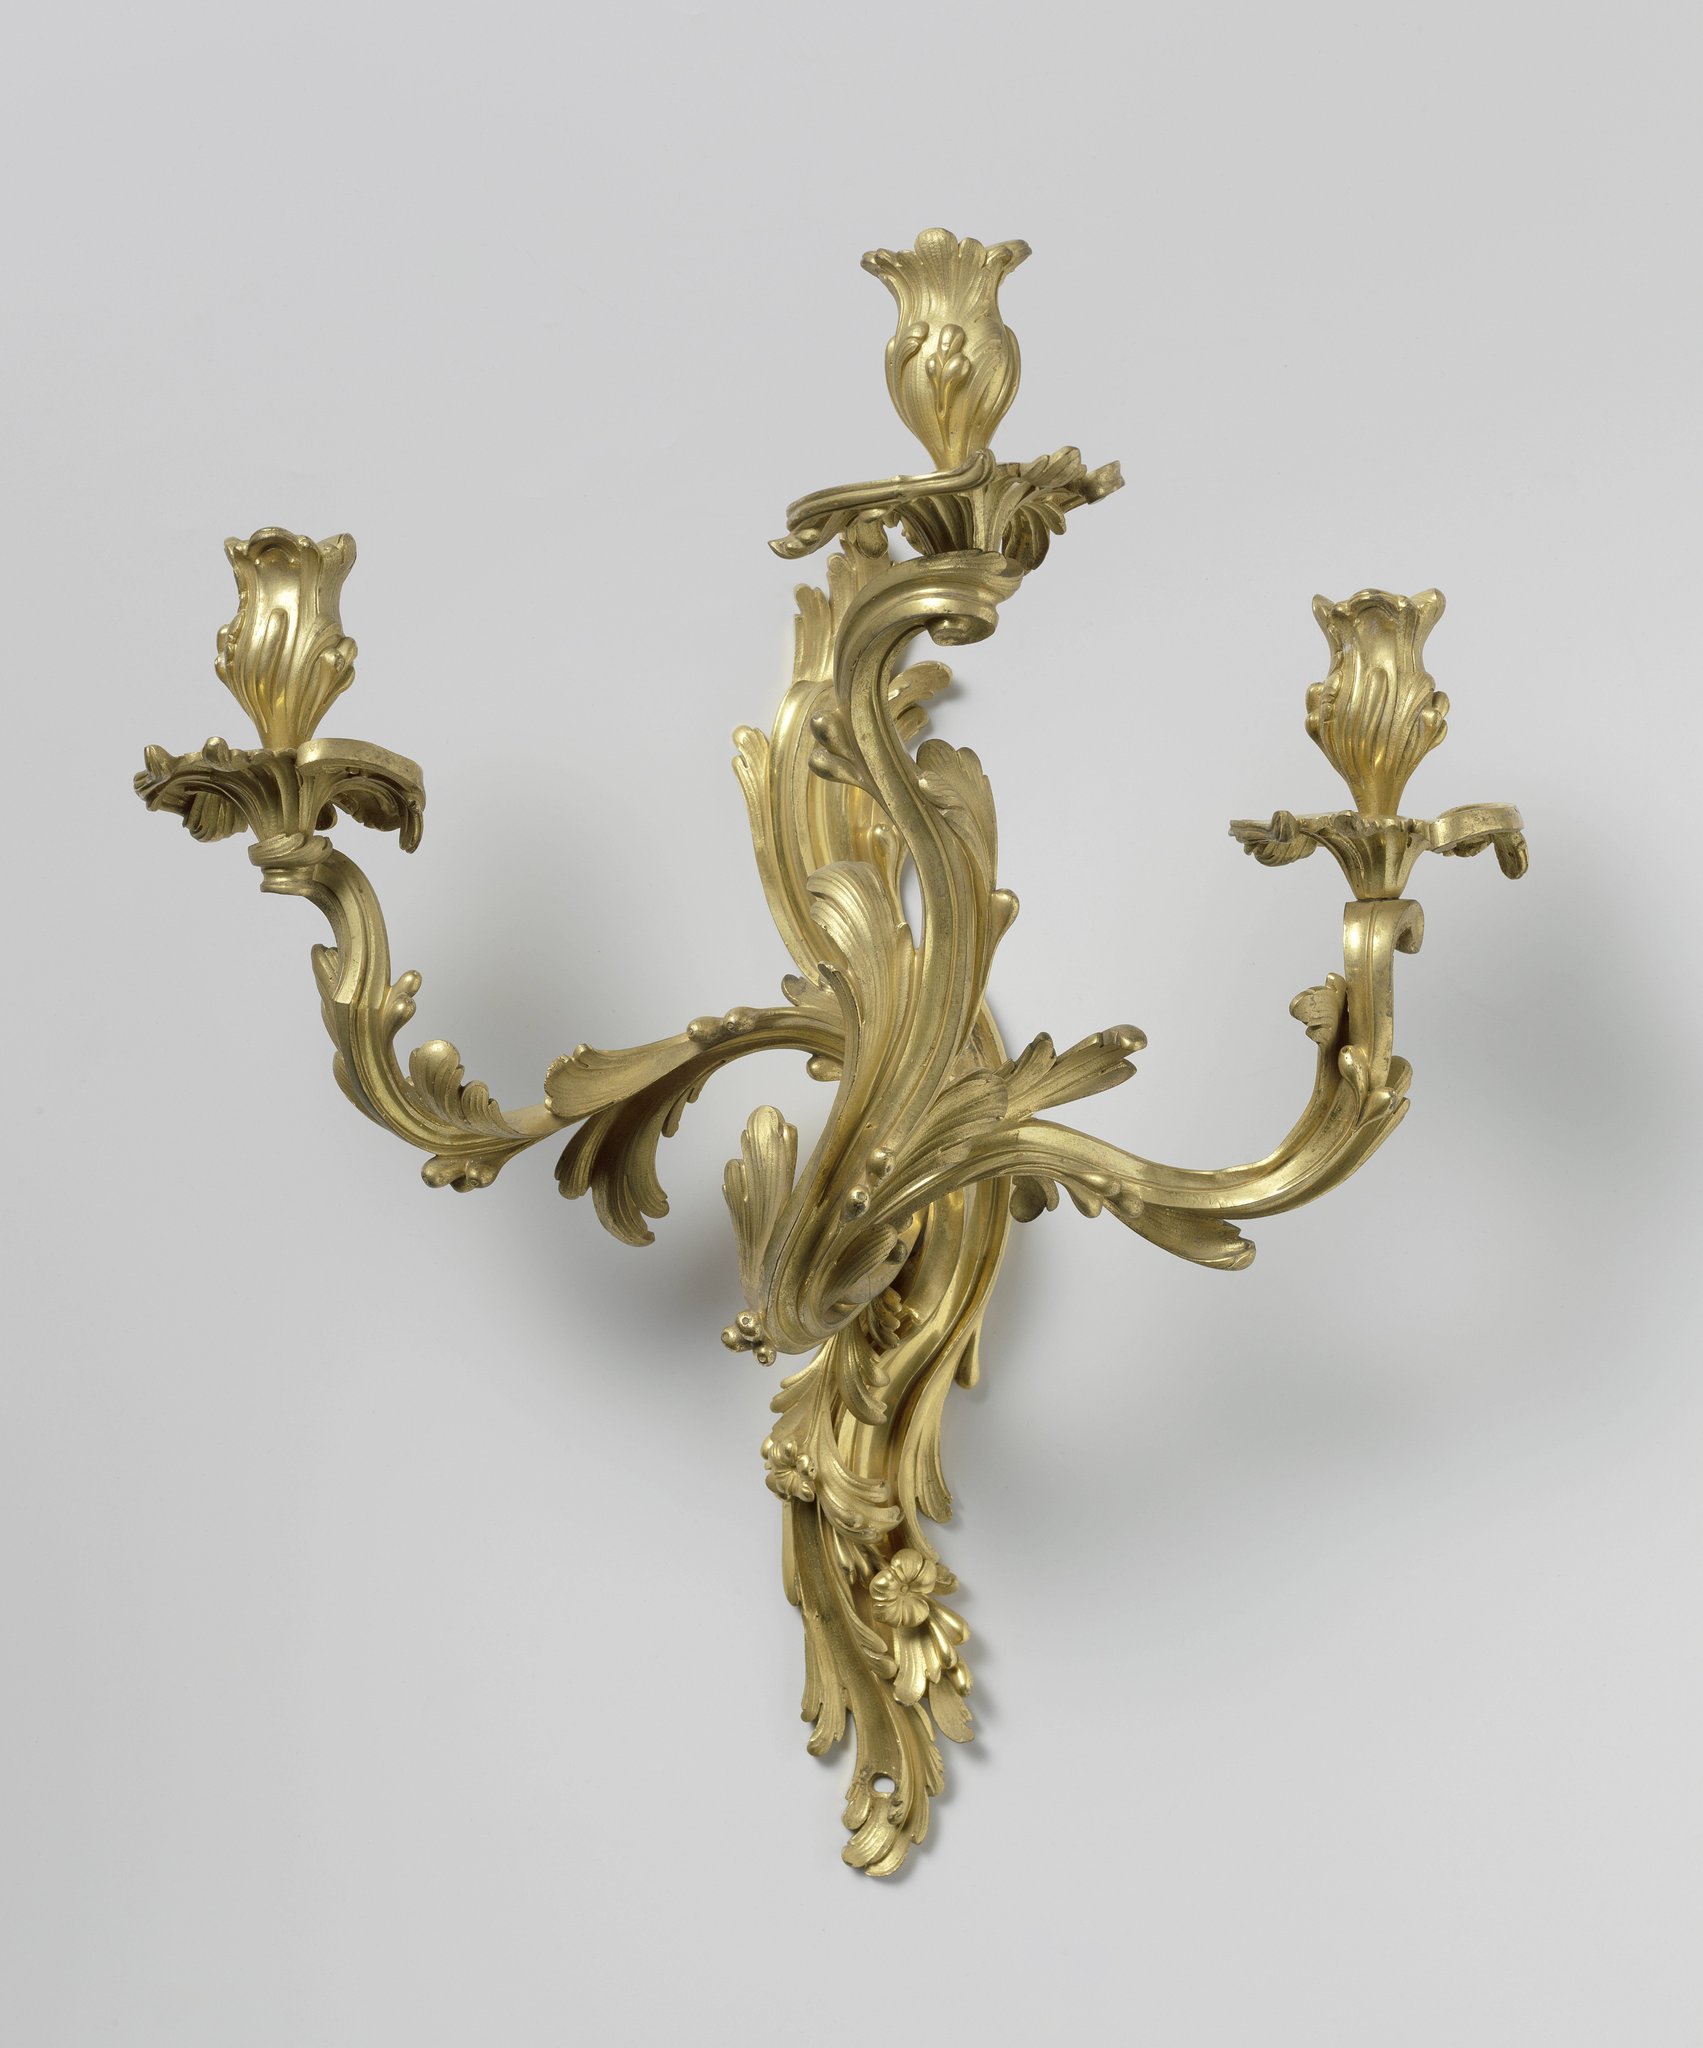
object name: lighting device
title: Wandarm van verguld brons met drie armen. Stam en armen zijn opgebouwd uit asymmetrische C- en S-vormige bladmotieven waartussen aan de onderkant bloemen zijn verwerkt.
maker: Anonymous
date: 1750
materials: bronze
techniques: gilding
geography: france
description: Verguld bronzen wandarm, met drie armen. De stam en de armen zijn opgebouwd uit asymmetrische S- en C-vormige bladmotieven, waartussen aan de onderkant bloemen zijn verwerkt. De vetvangers en kaarsenhouders vertonen eveneens bladmotieven. Zie tevens: BK-16897-a-c/d.